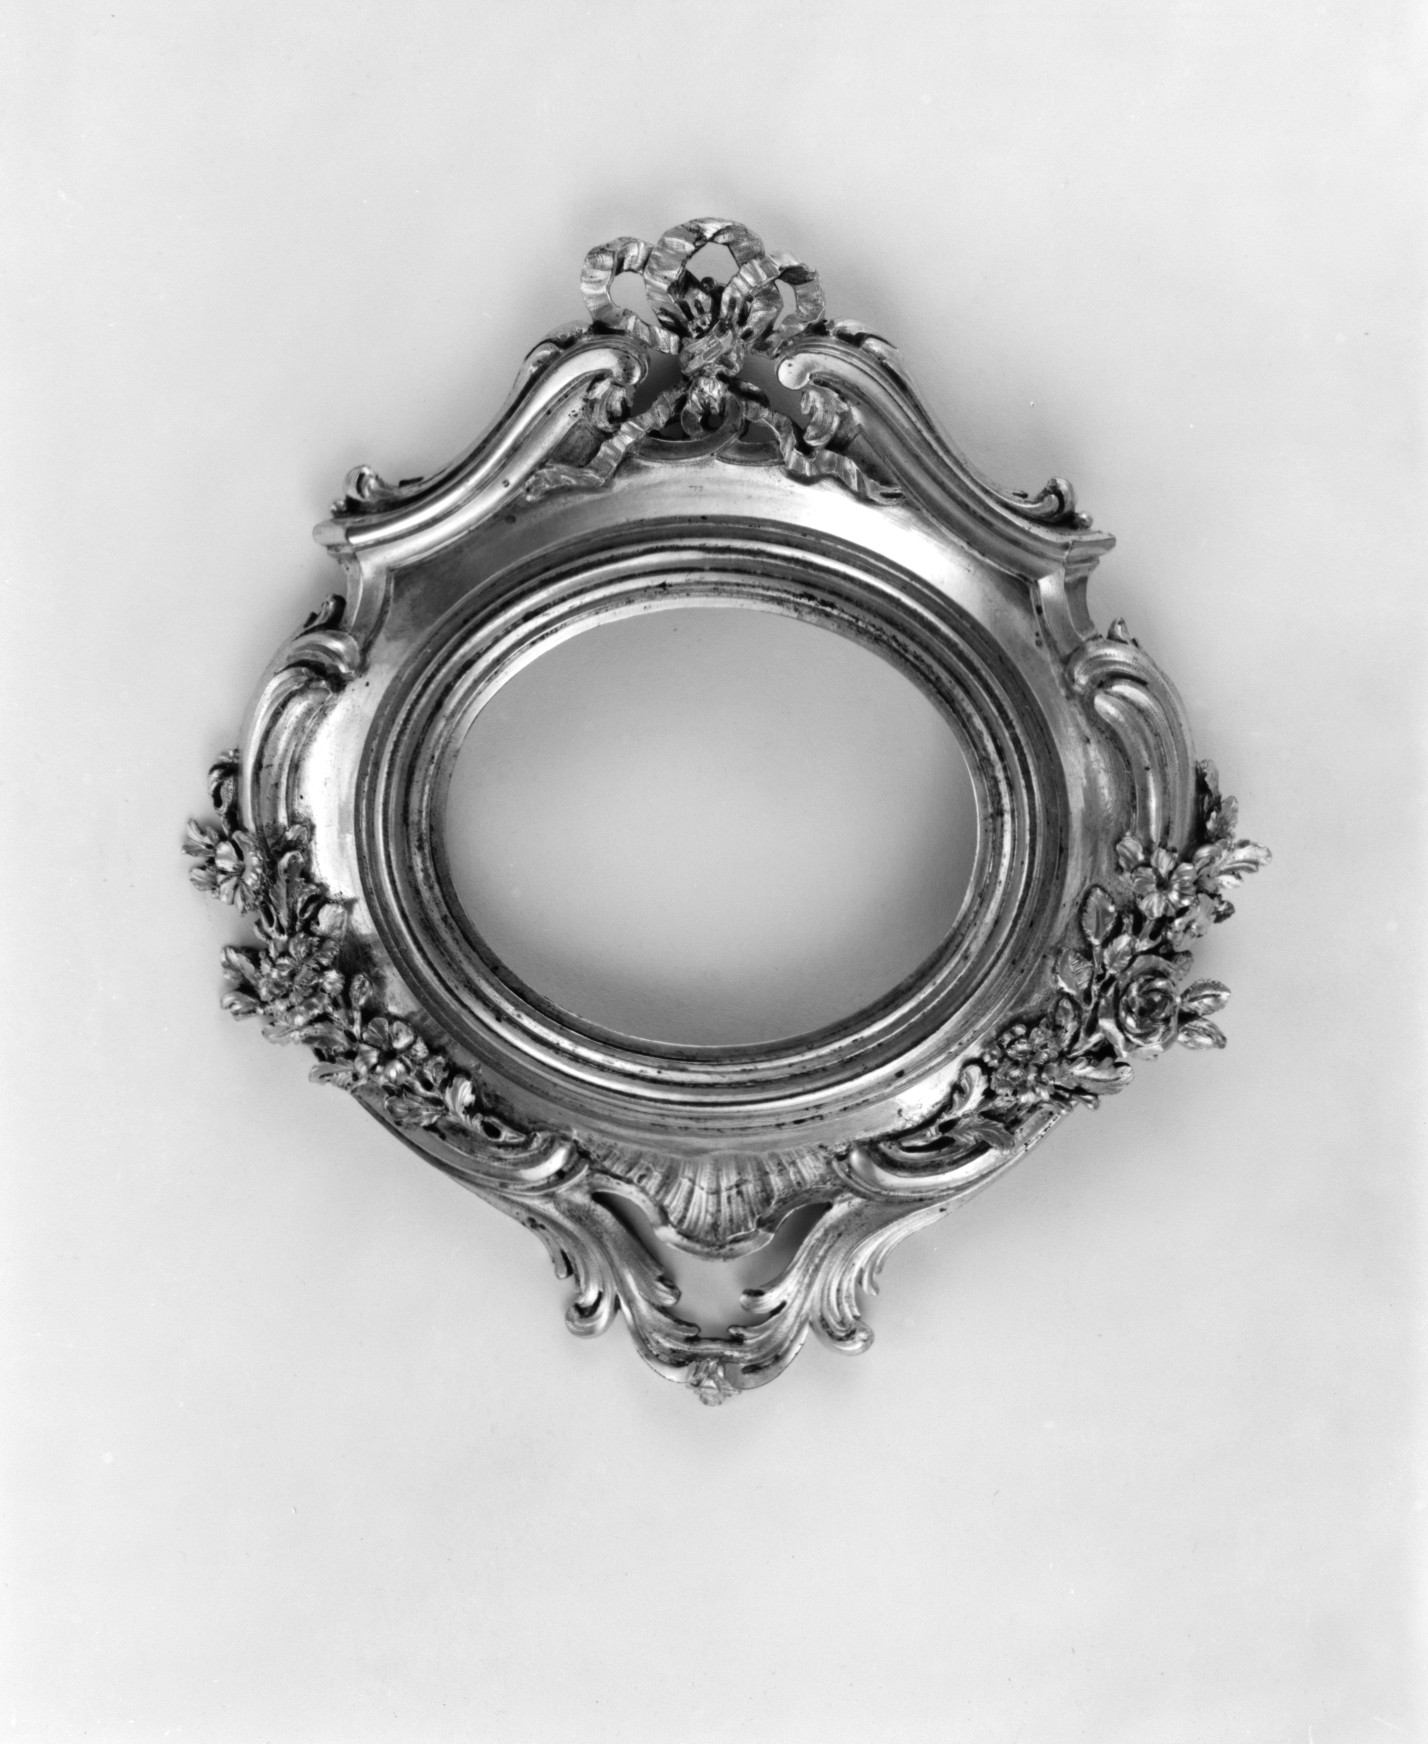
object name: frame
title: Miniature oval frame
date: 1765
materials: gilt bronze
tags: flowers